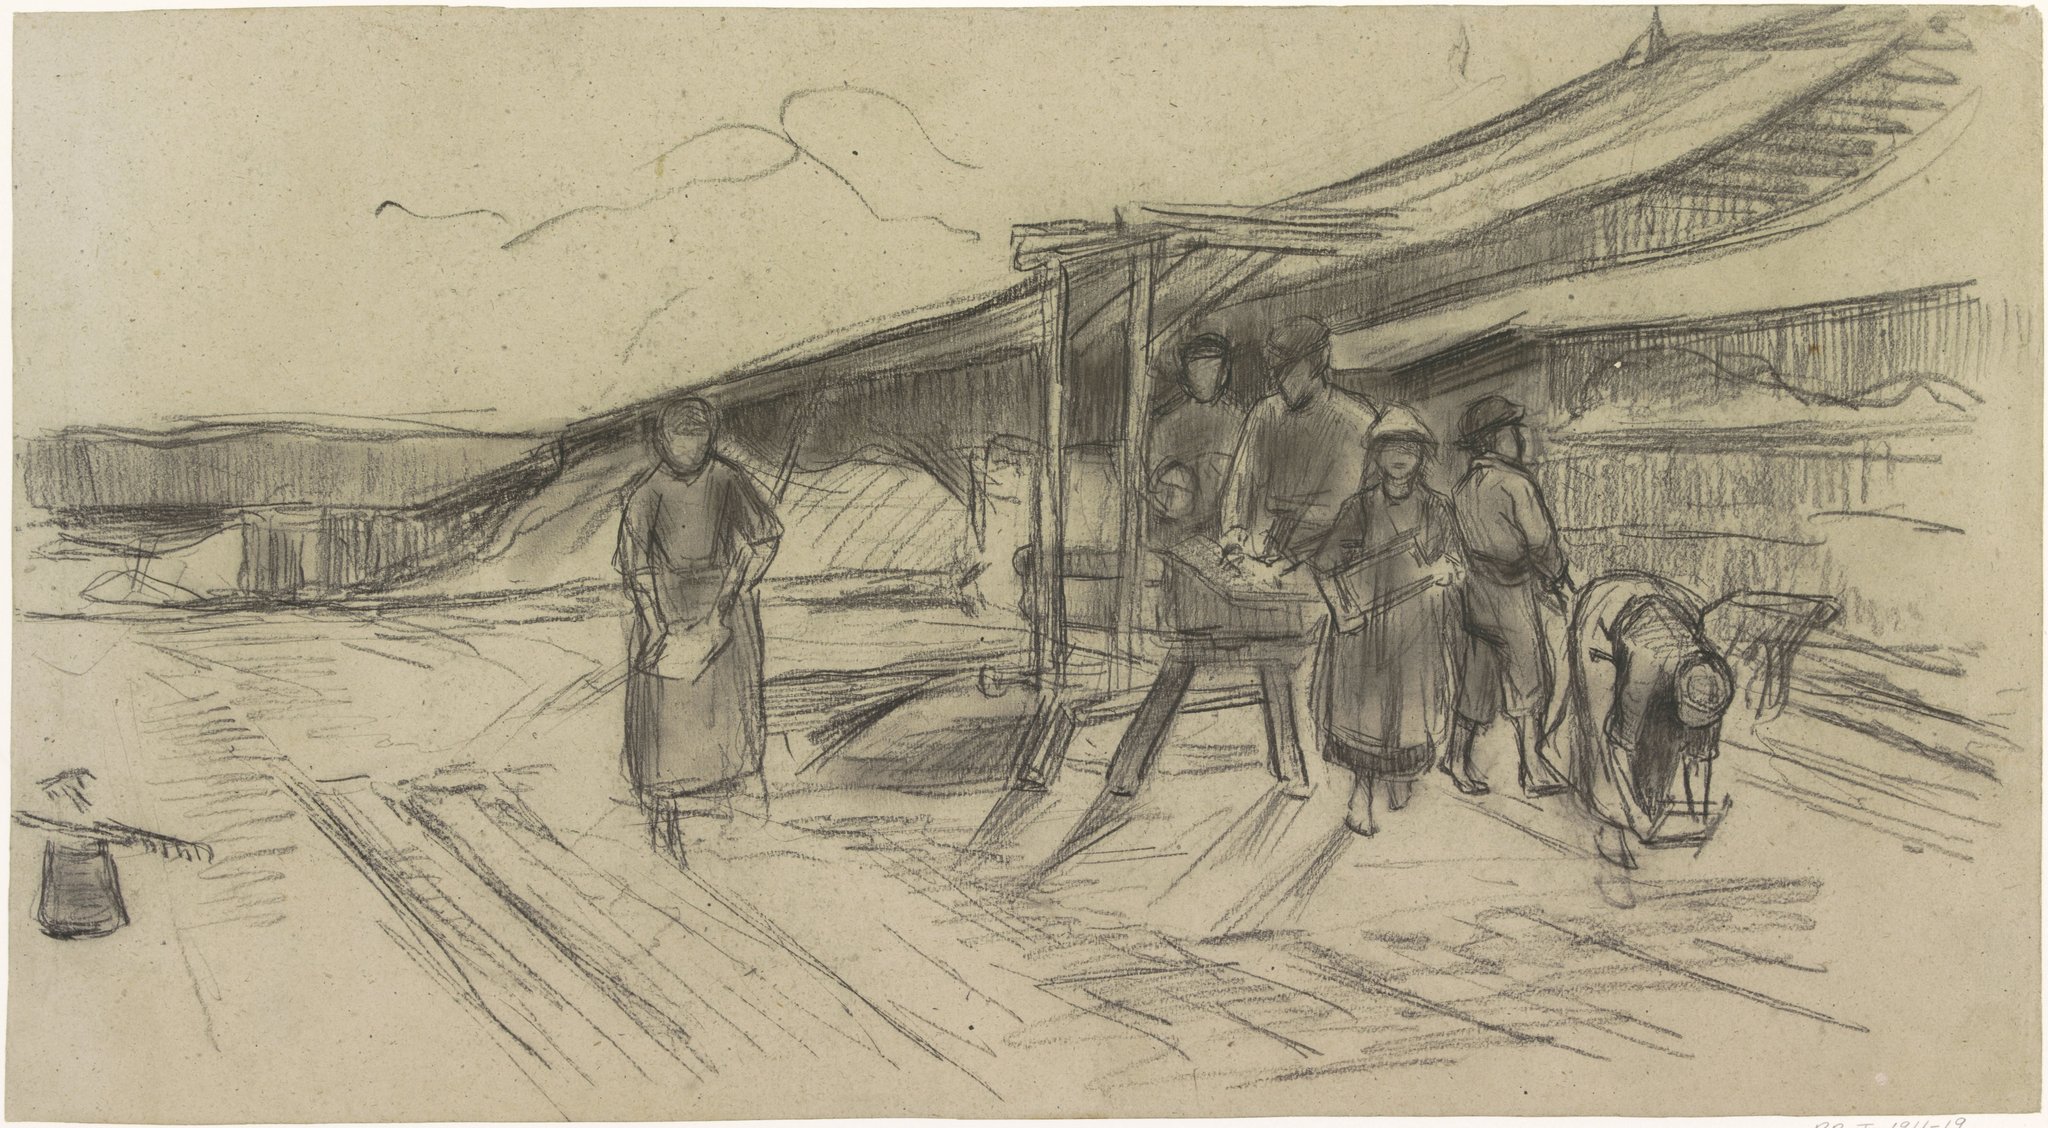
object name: drawing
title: De steenfabriek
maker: anthon gerhard alexander van rappard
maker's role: draughtsman, print maker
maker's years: 1858-1892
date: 1868-1892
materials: charcoal, paper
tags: brick works